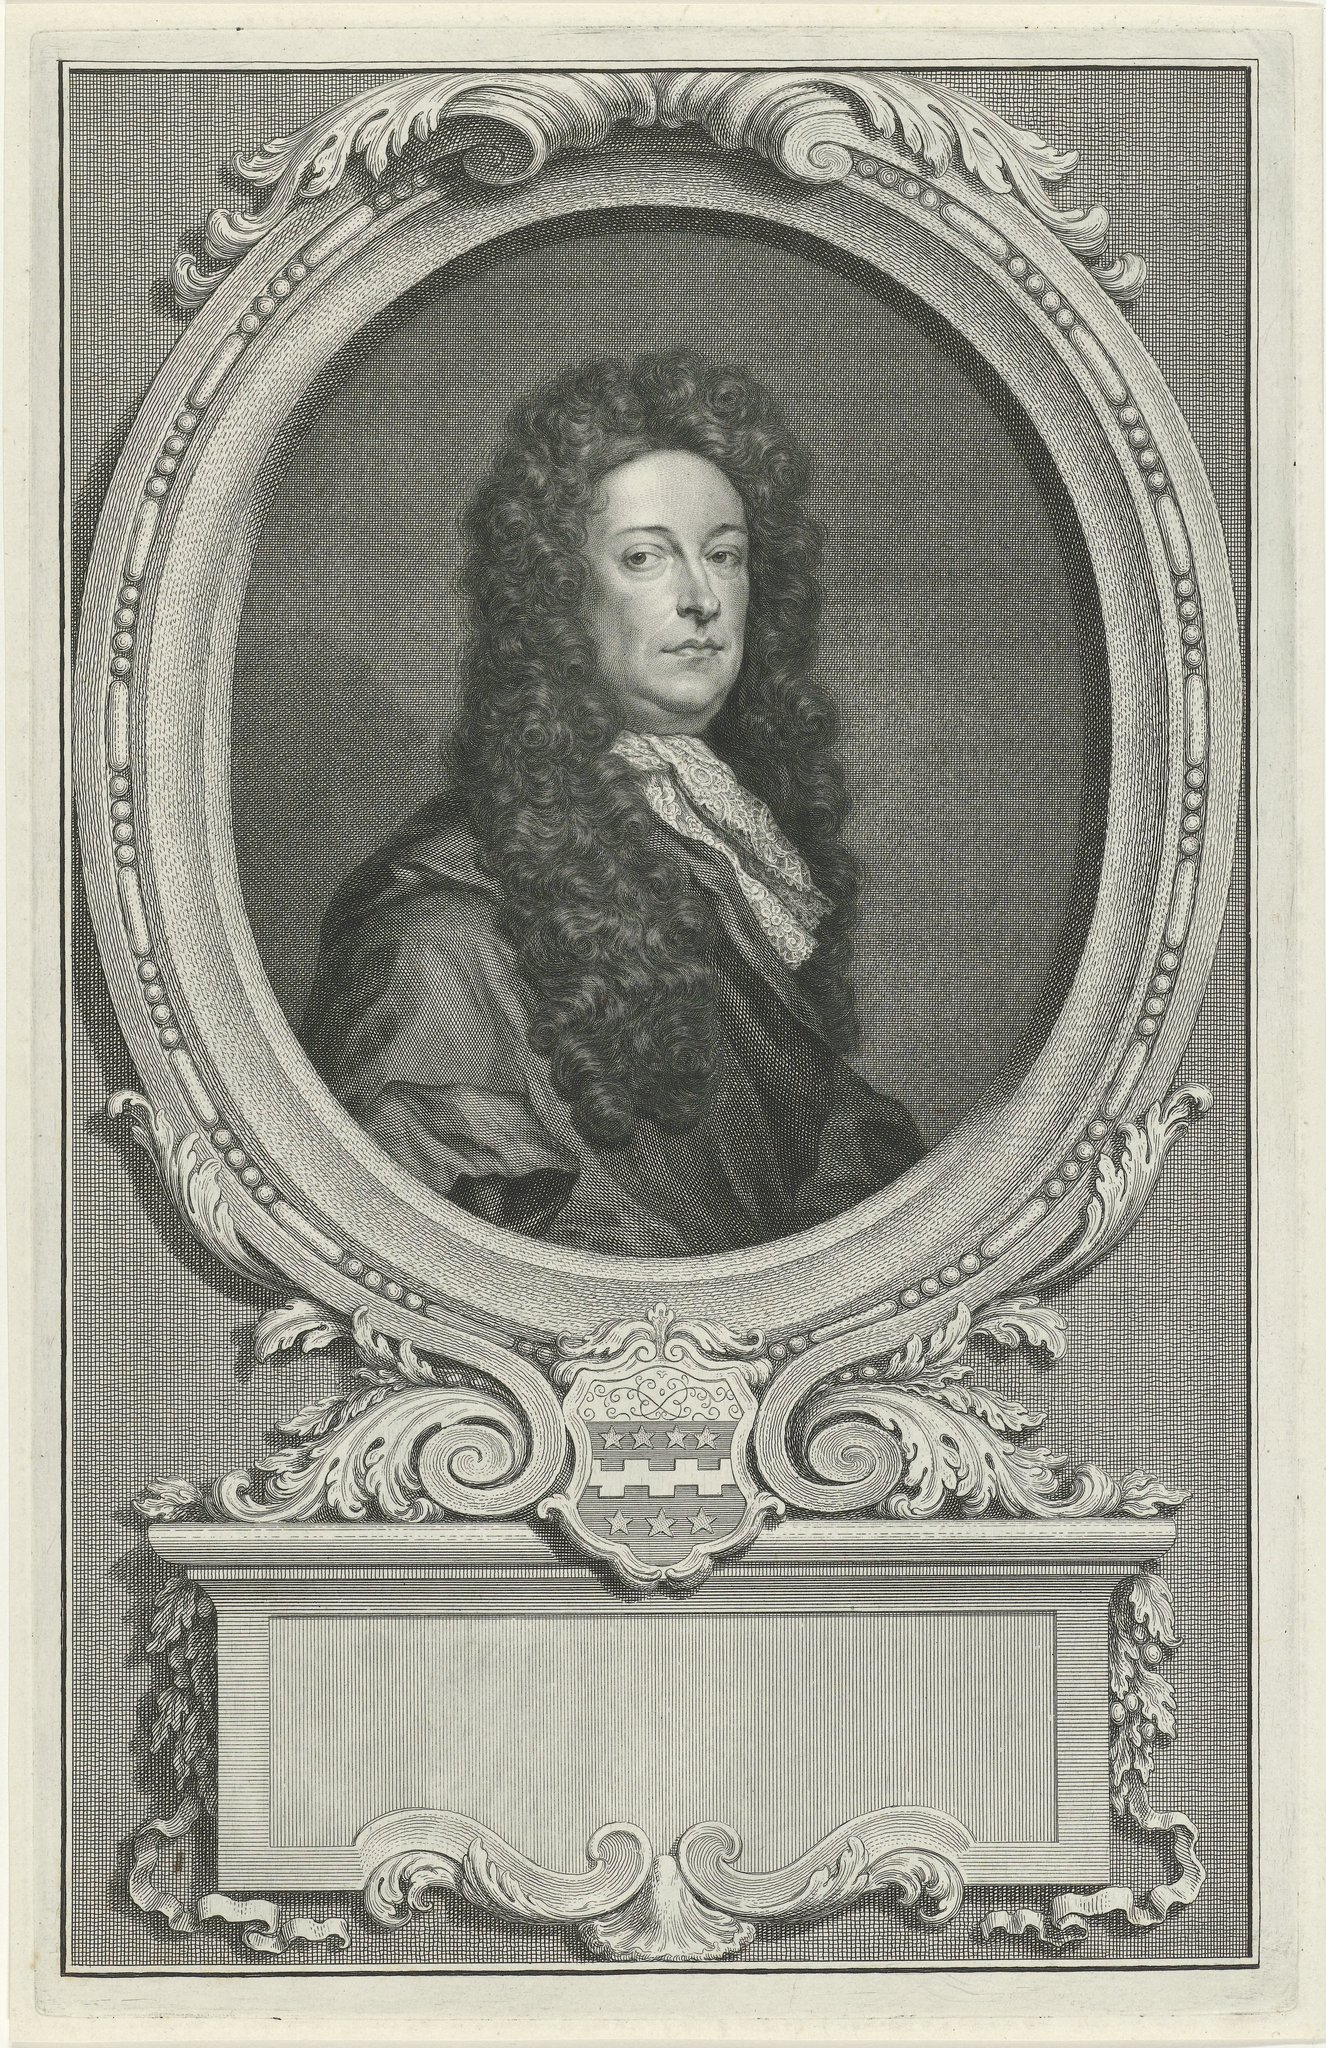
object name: print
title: Portret van Aernout van Citters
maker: jacob houbraken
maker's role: draughtsman, print maker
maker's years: 1698-1780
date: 1708-1780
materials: paper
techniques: engraving, etching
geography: amsterdam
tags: ambassadeur, aernout van citters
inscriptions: collector's mark: Lugt 240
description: Buste naar rechts van Aernout van Citters, in een ornamentele ovale omlijsting met onderaan zijn wapen en een piëdestal met een leeg veld voor zijn naam.